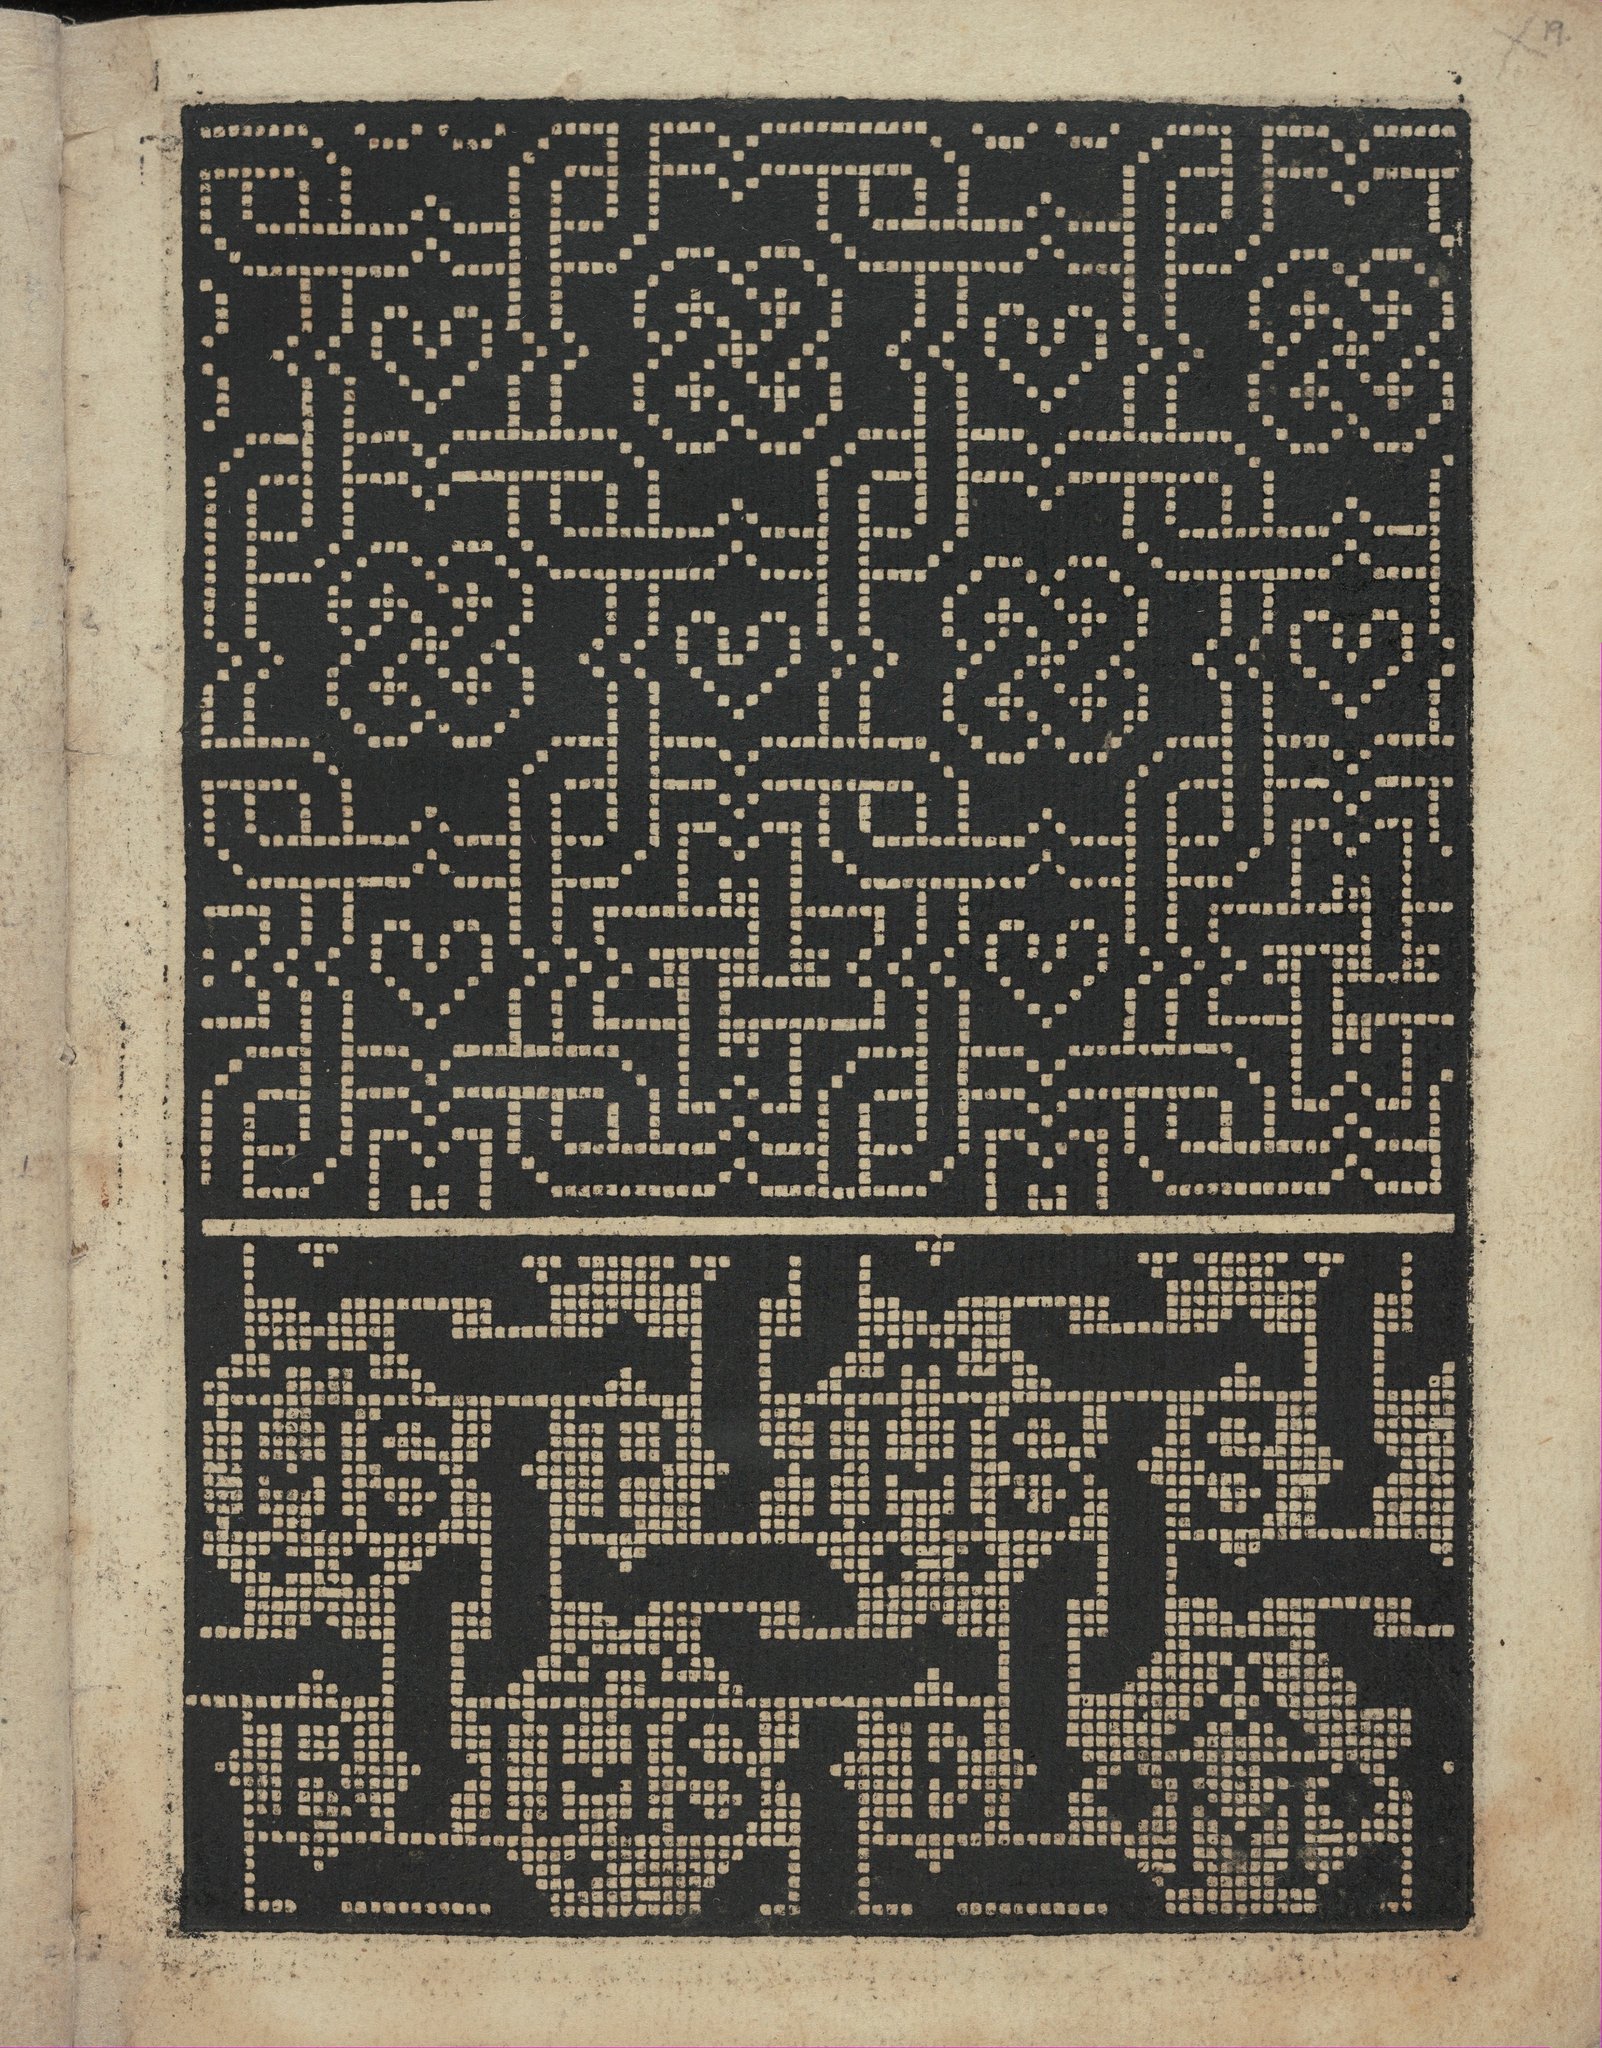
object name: book print ornament architecture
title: Libbretto nouellamete composto per maestro Domenico da Sera...lauorare di ogni sorte di punti, page 19 (recto)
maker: domenico da sera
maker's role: publisher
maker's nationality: french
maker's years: 1500-1599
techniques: woodcut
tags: ornament